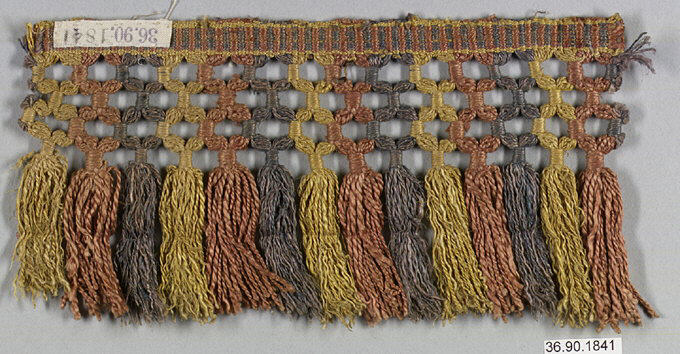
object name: fringe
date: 1667-1700